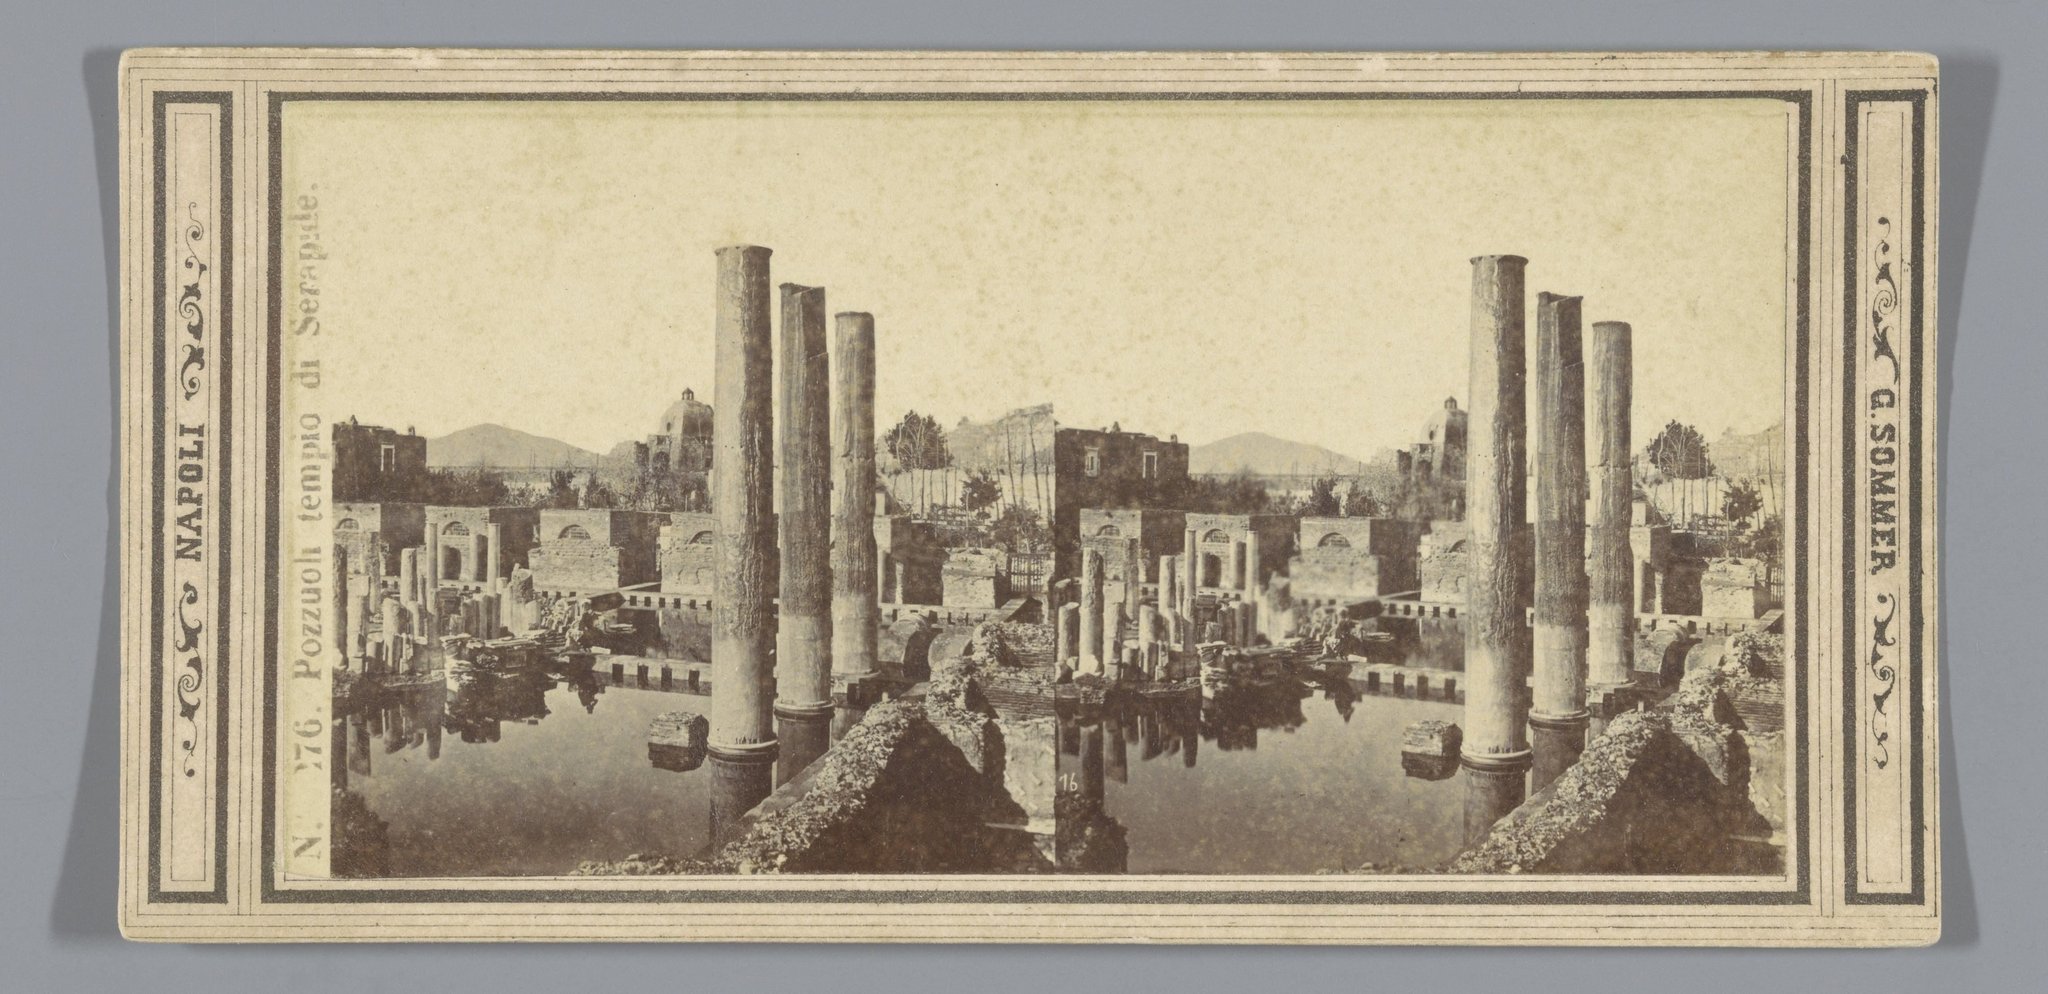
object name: stereograph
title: Gezicht op de ruïne van het Macellum di Pozzuoli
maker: giorgio sommer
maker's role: fotograaf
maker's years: 1834-1914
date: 1860-1880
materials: cardboard, photographic support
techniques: albumen print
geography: pozzuoli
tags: ruin of a building ~ architecture, pozzuoli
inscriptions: number: ‘L. 2.’, number: ‘N. 276.’